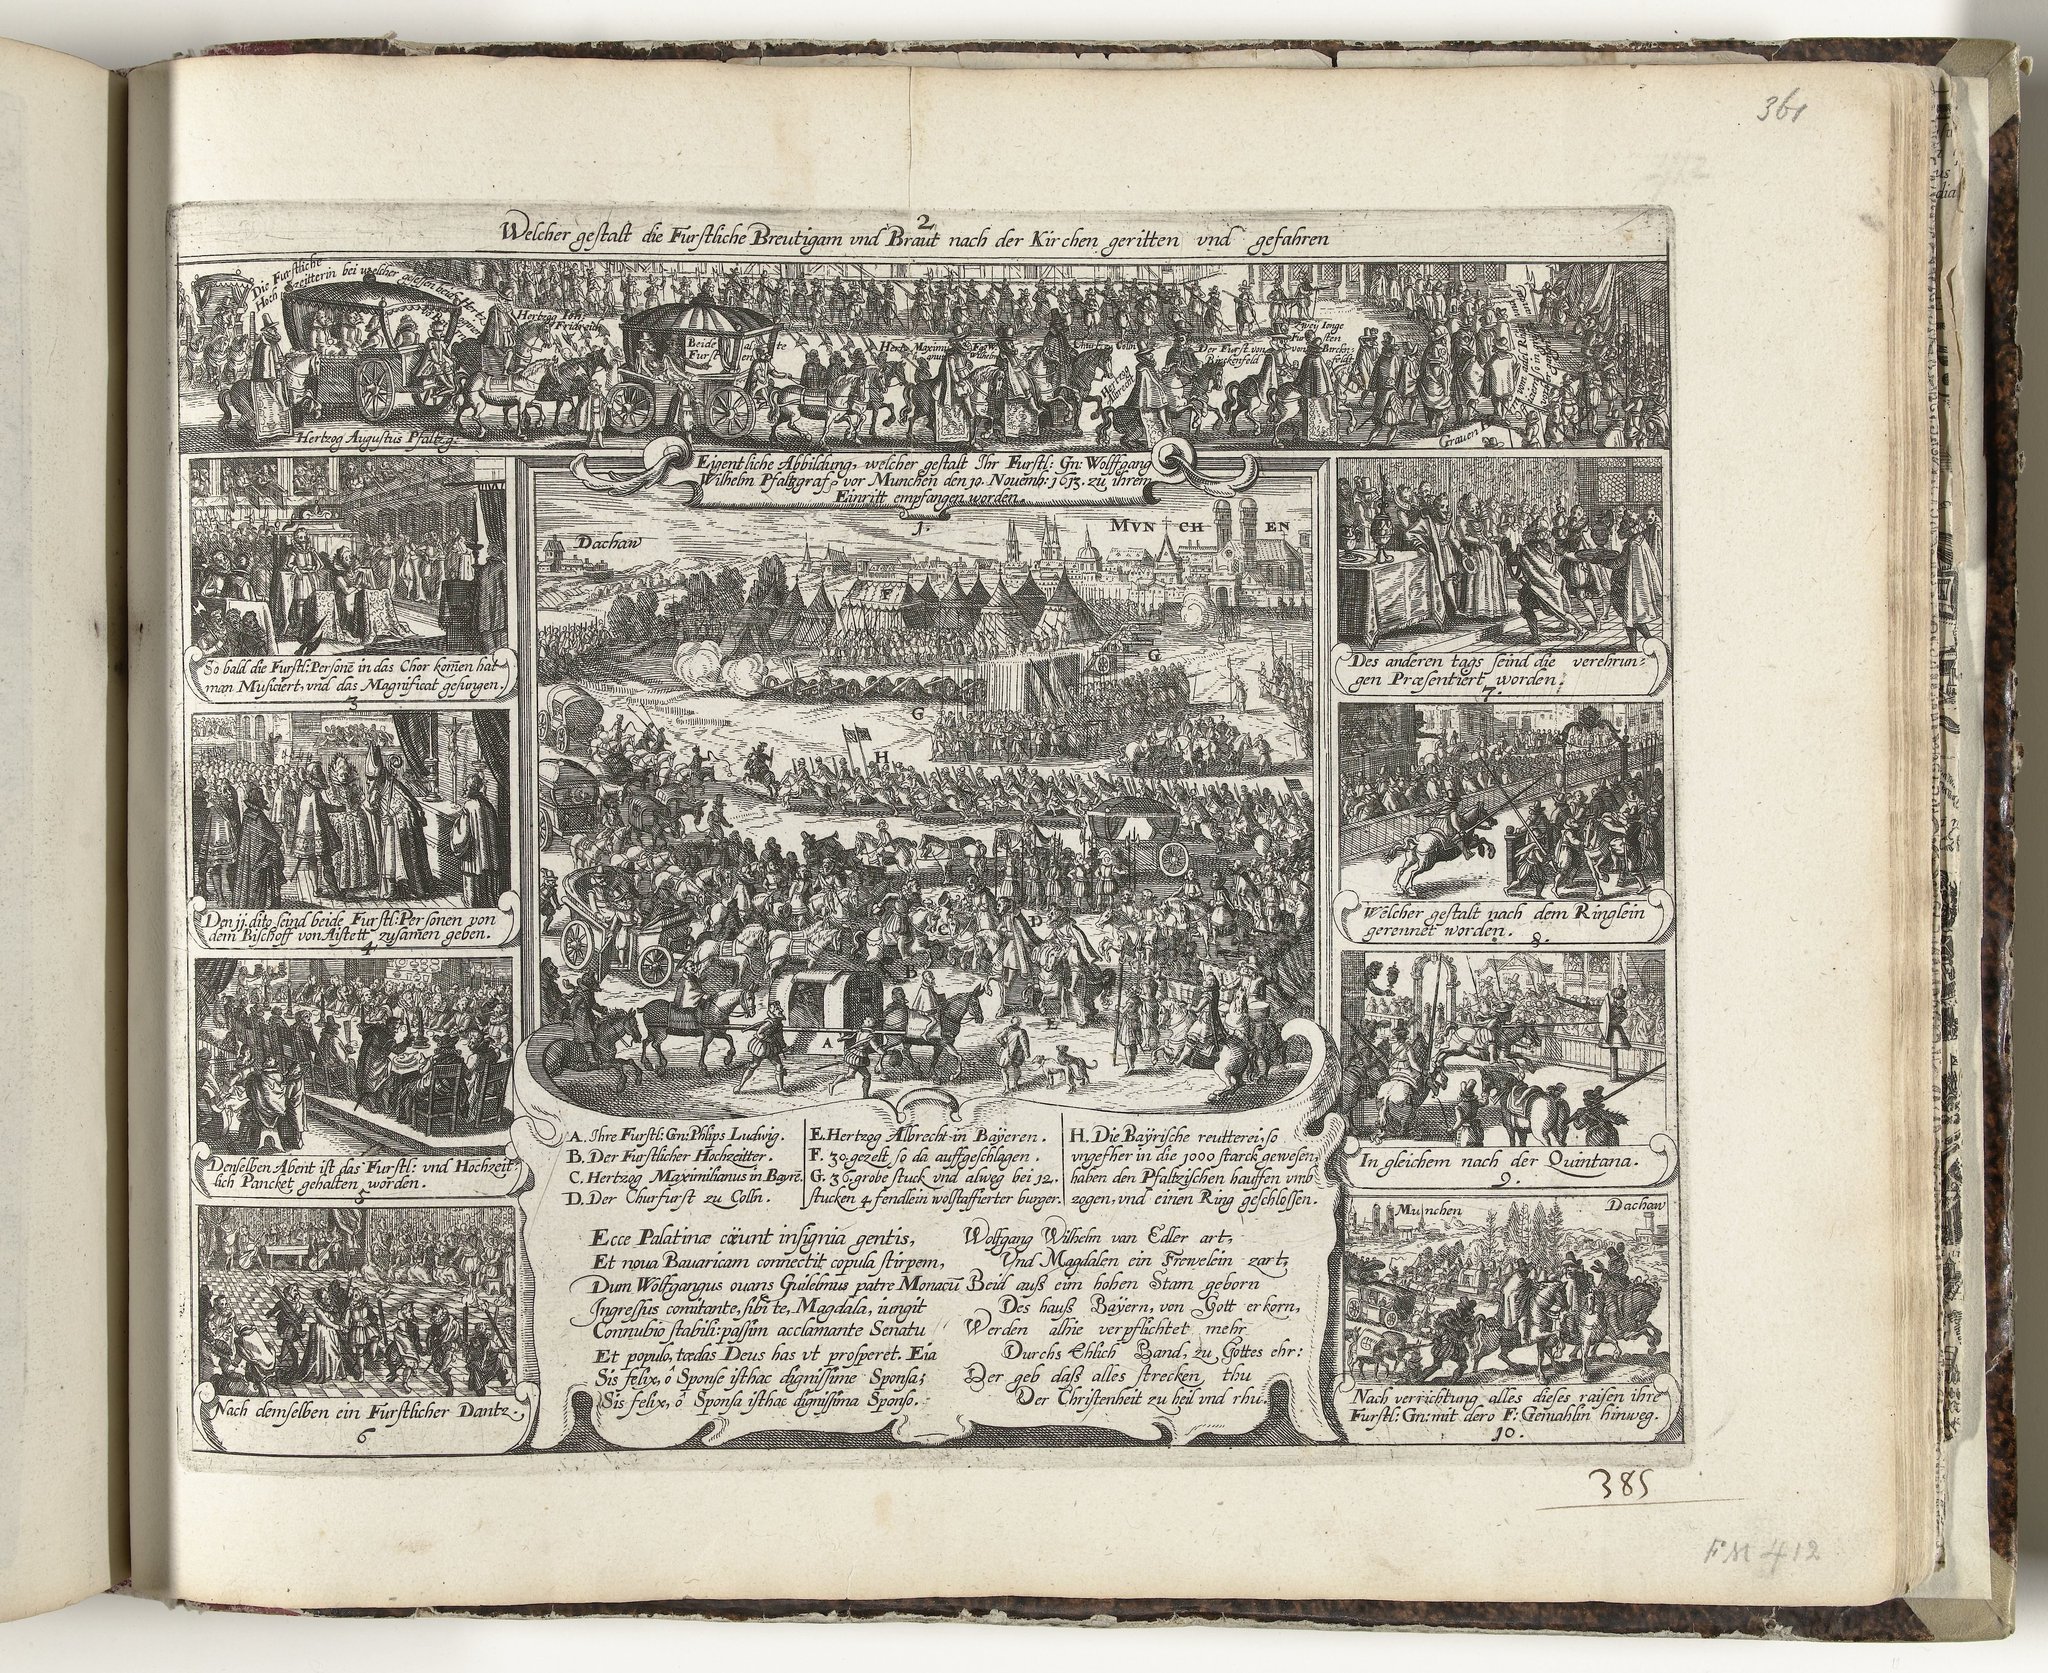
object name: album leaf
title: Eigentliche Abbildung, welcher gestalt Ihr Furstl. Gn. Wolffgang Wilhelm Pfaltzgraf vor Munchen den 10. Novemb. 1613. zu ihrem Einritt empfangen worden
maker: frans hogenberg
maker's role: print maker, publisher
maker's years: 1538-1590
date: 1613-1615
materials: paper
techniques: etching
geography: cologne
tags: wolfgang willem van de palts-neuburg, (civil) marriage ceremonies, public festivities at marriage of royal persons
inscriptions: inscription: ‘385’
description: Huwelijk van paltsgraaf Wolfgang Wilhelm von Pfalz-Neuberg met Magdalena van Beieren, te München op 10 november 1613. Centrale voorstelling omringd door negen kleinere scènes van de gebeurtenissen rond het huwelijk. Scènes genummerd 1-10. Onderaan de legenda A-H en een vers van 8 regels in het Latijn en 8 regels in het Duits. Rechtsonder met pen genummerd: 385. De prent maakt deel uit van een album.